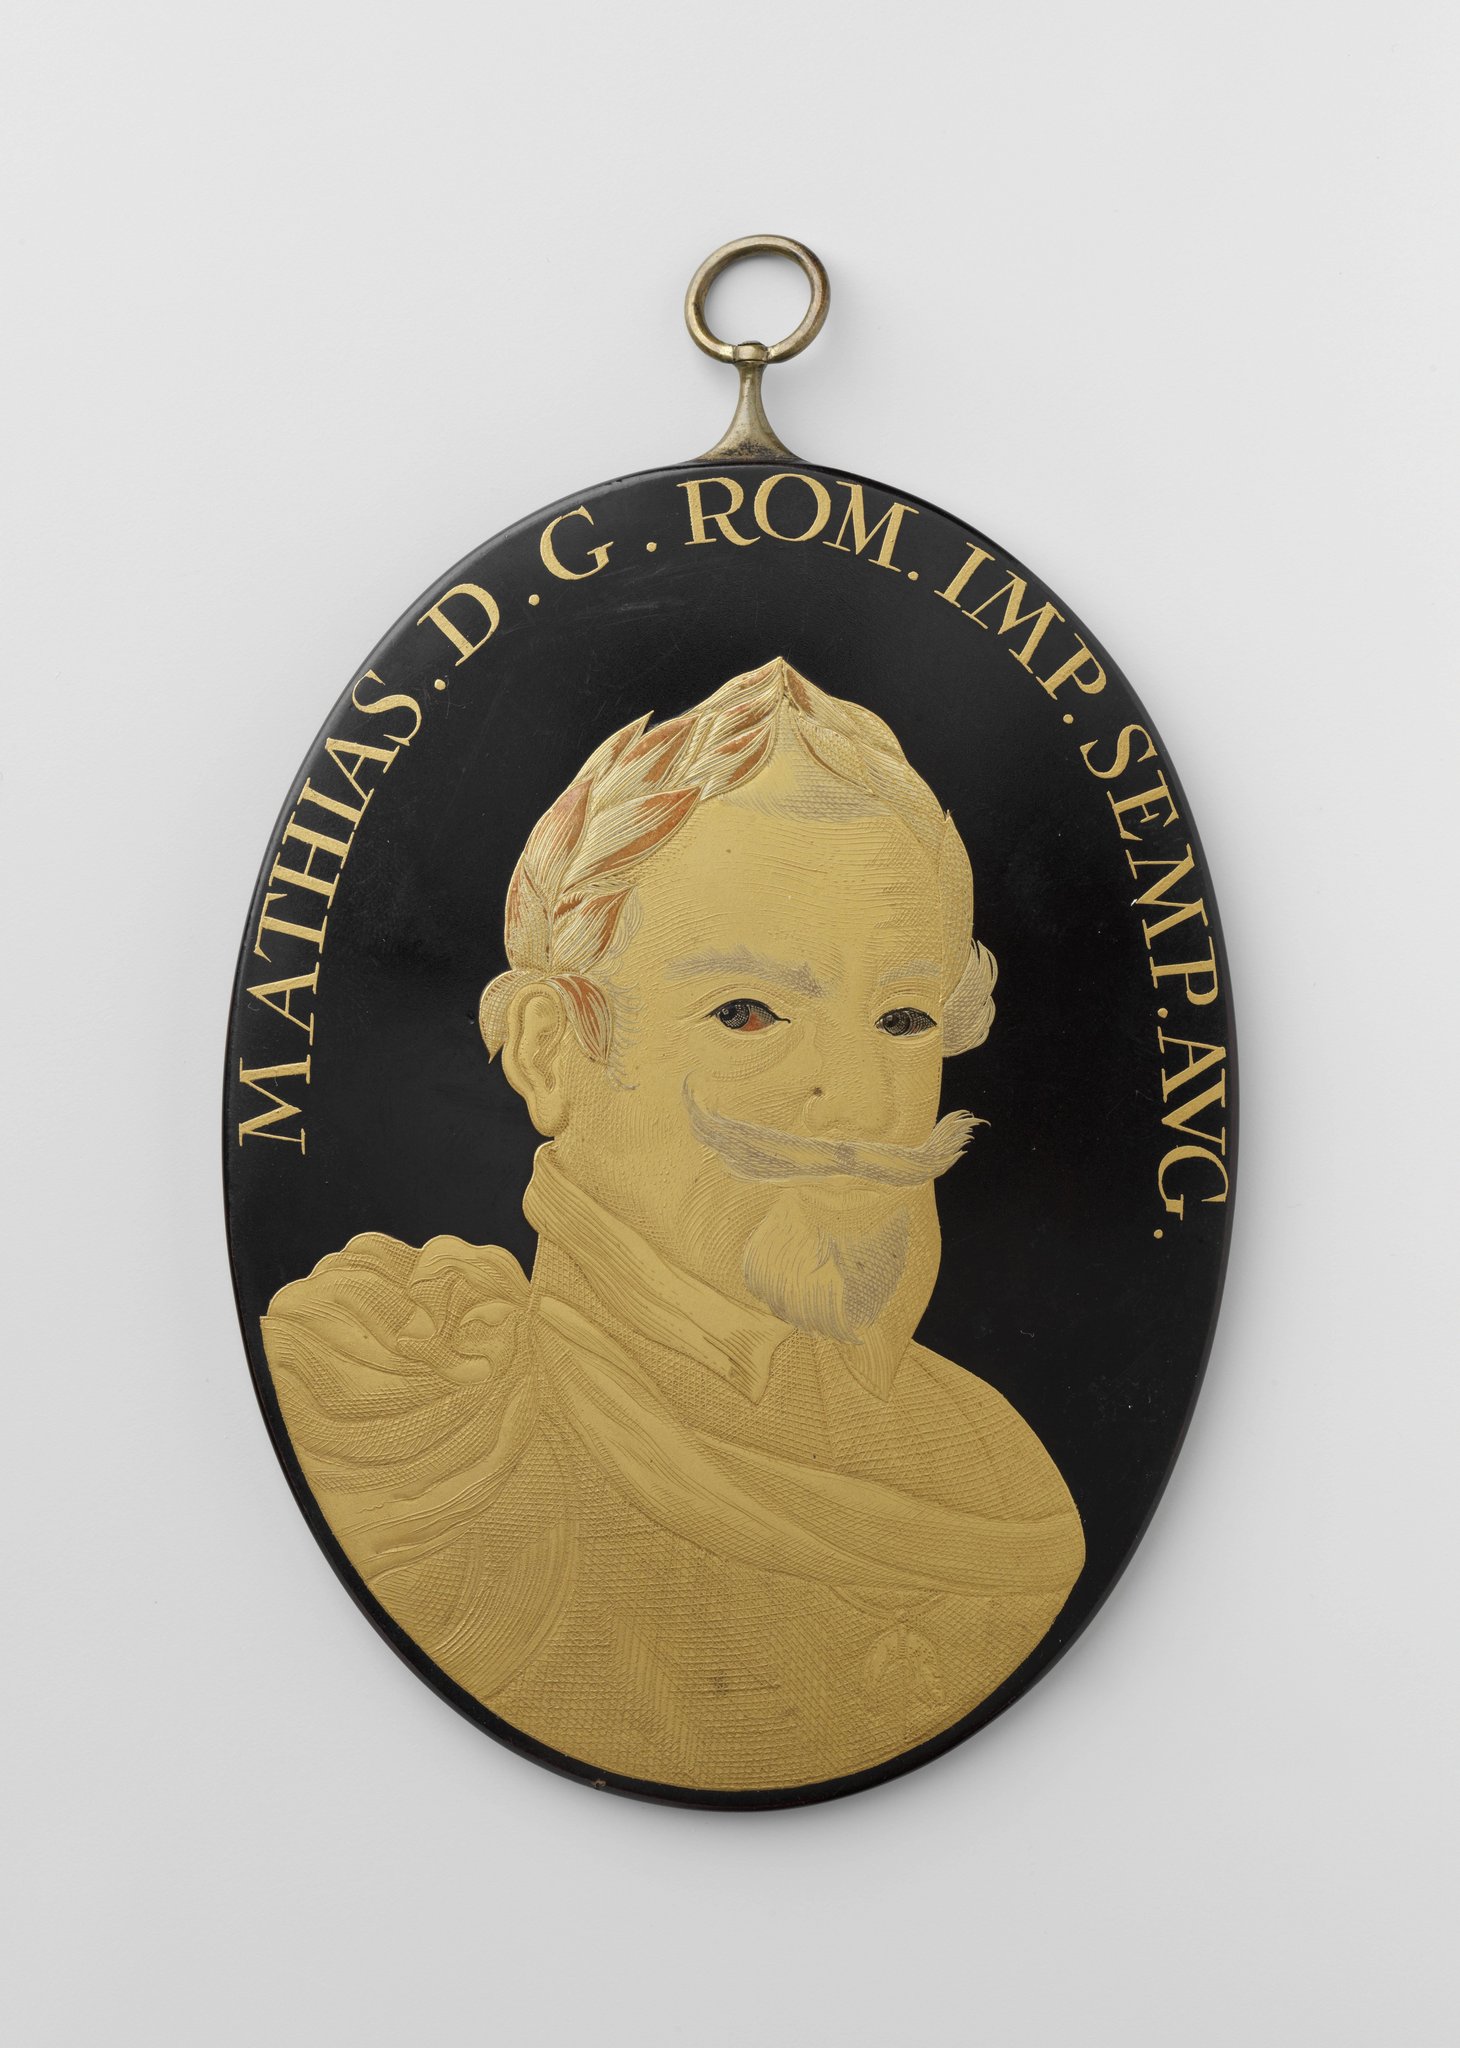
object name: plaque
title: Portret van keizer Mathias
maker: Anonymous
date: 1775-1800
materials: copper, lacquer, paint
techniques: lacquer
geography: japan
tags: matthias van oostenrijk (rooms-duits keizer)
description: Ovale plaquette met portret van een man, borststuk, met lauwerkrans, mantel om de schouders en orde (van het Gulden Vlies). In goud op zwart, rood op de lauwerkrans en in de ogen, gouden randschrift boven: MATHIAS. D. G. ROM. IMP. SEMP. AVG. Keerzijde opschrift in goud op zwart: MATHIAS Austriacus, Vienna natus, Imperav. an. Vlmens. VIII di XXVI / sedete Paulo V. decessit, an Chr. MDCXIX. Boven draaibaar draagoog.